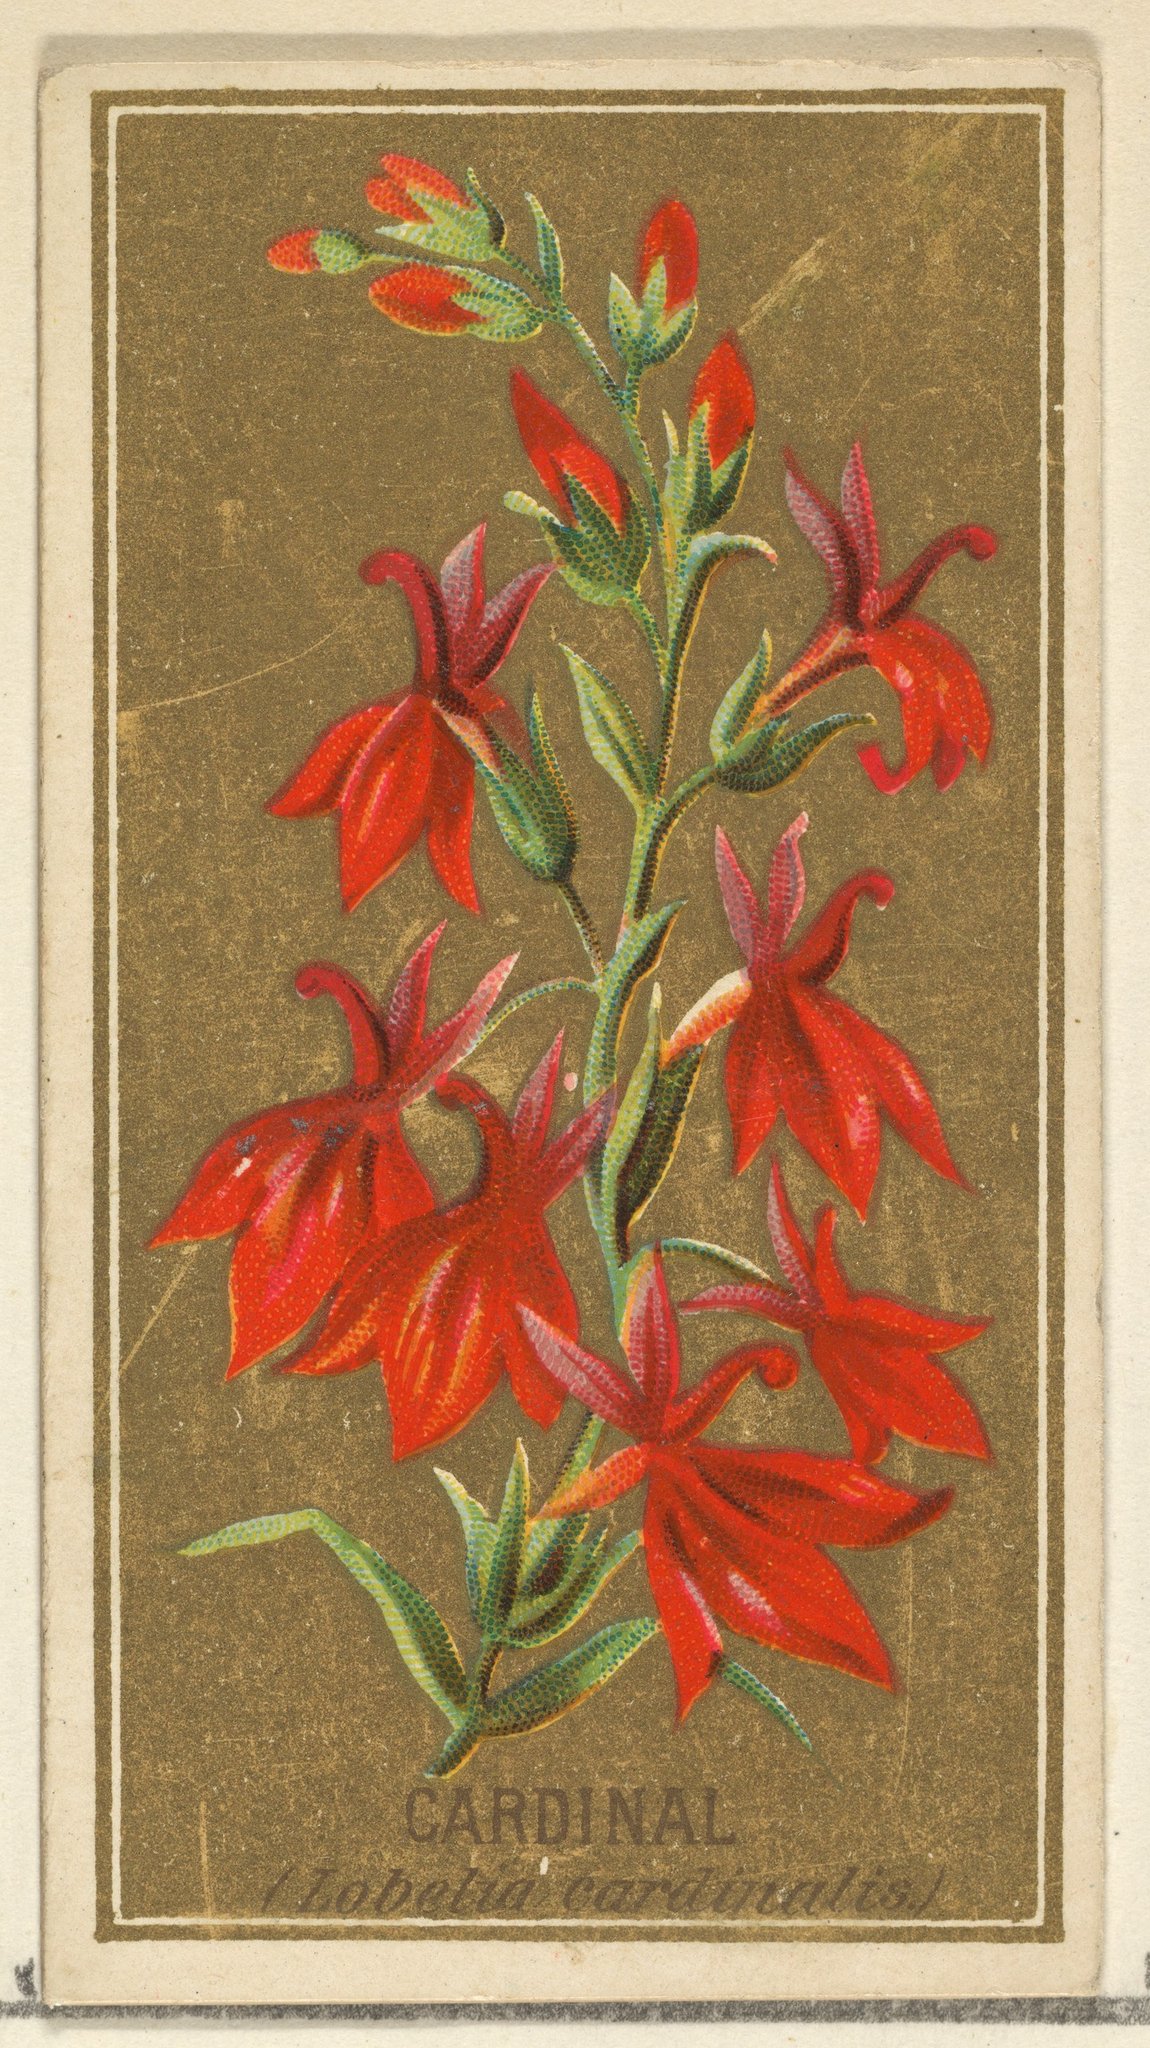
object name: print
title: Cardinal (Lobelia cardinalis), from the Flowers series for Old Judge Cigarettes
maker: goodwin & company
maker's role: publisher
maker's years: 1850-1950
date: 1890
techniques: color lithograph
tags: flowers